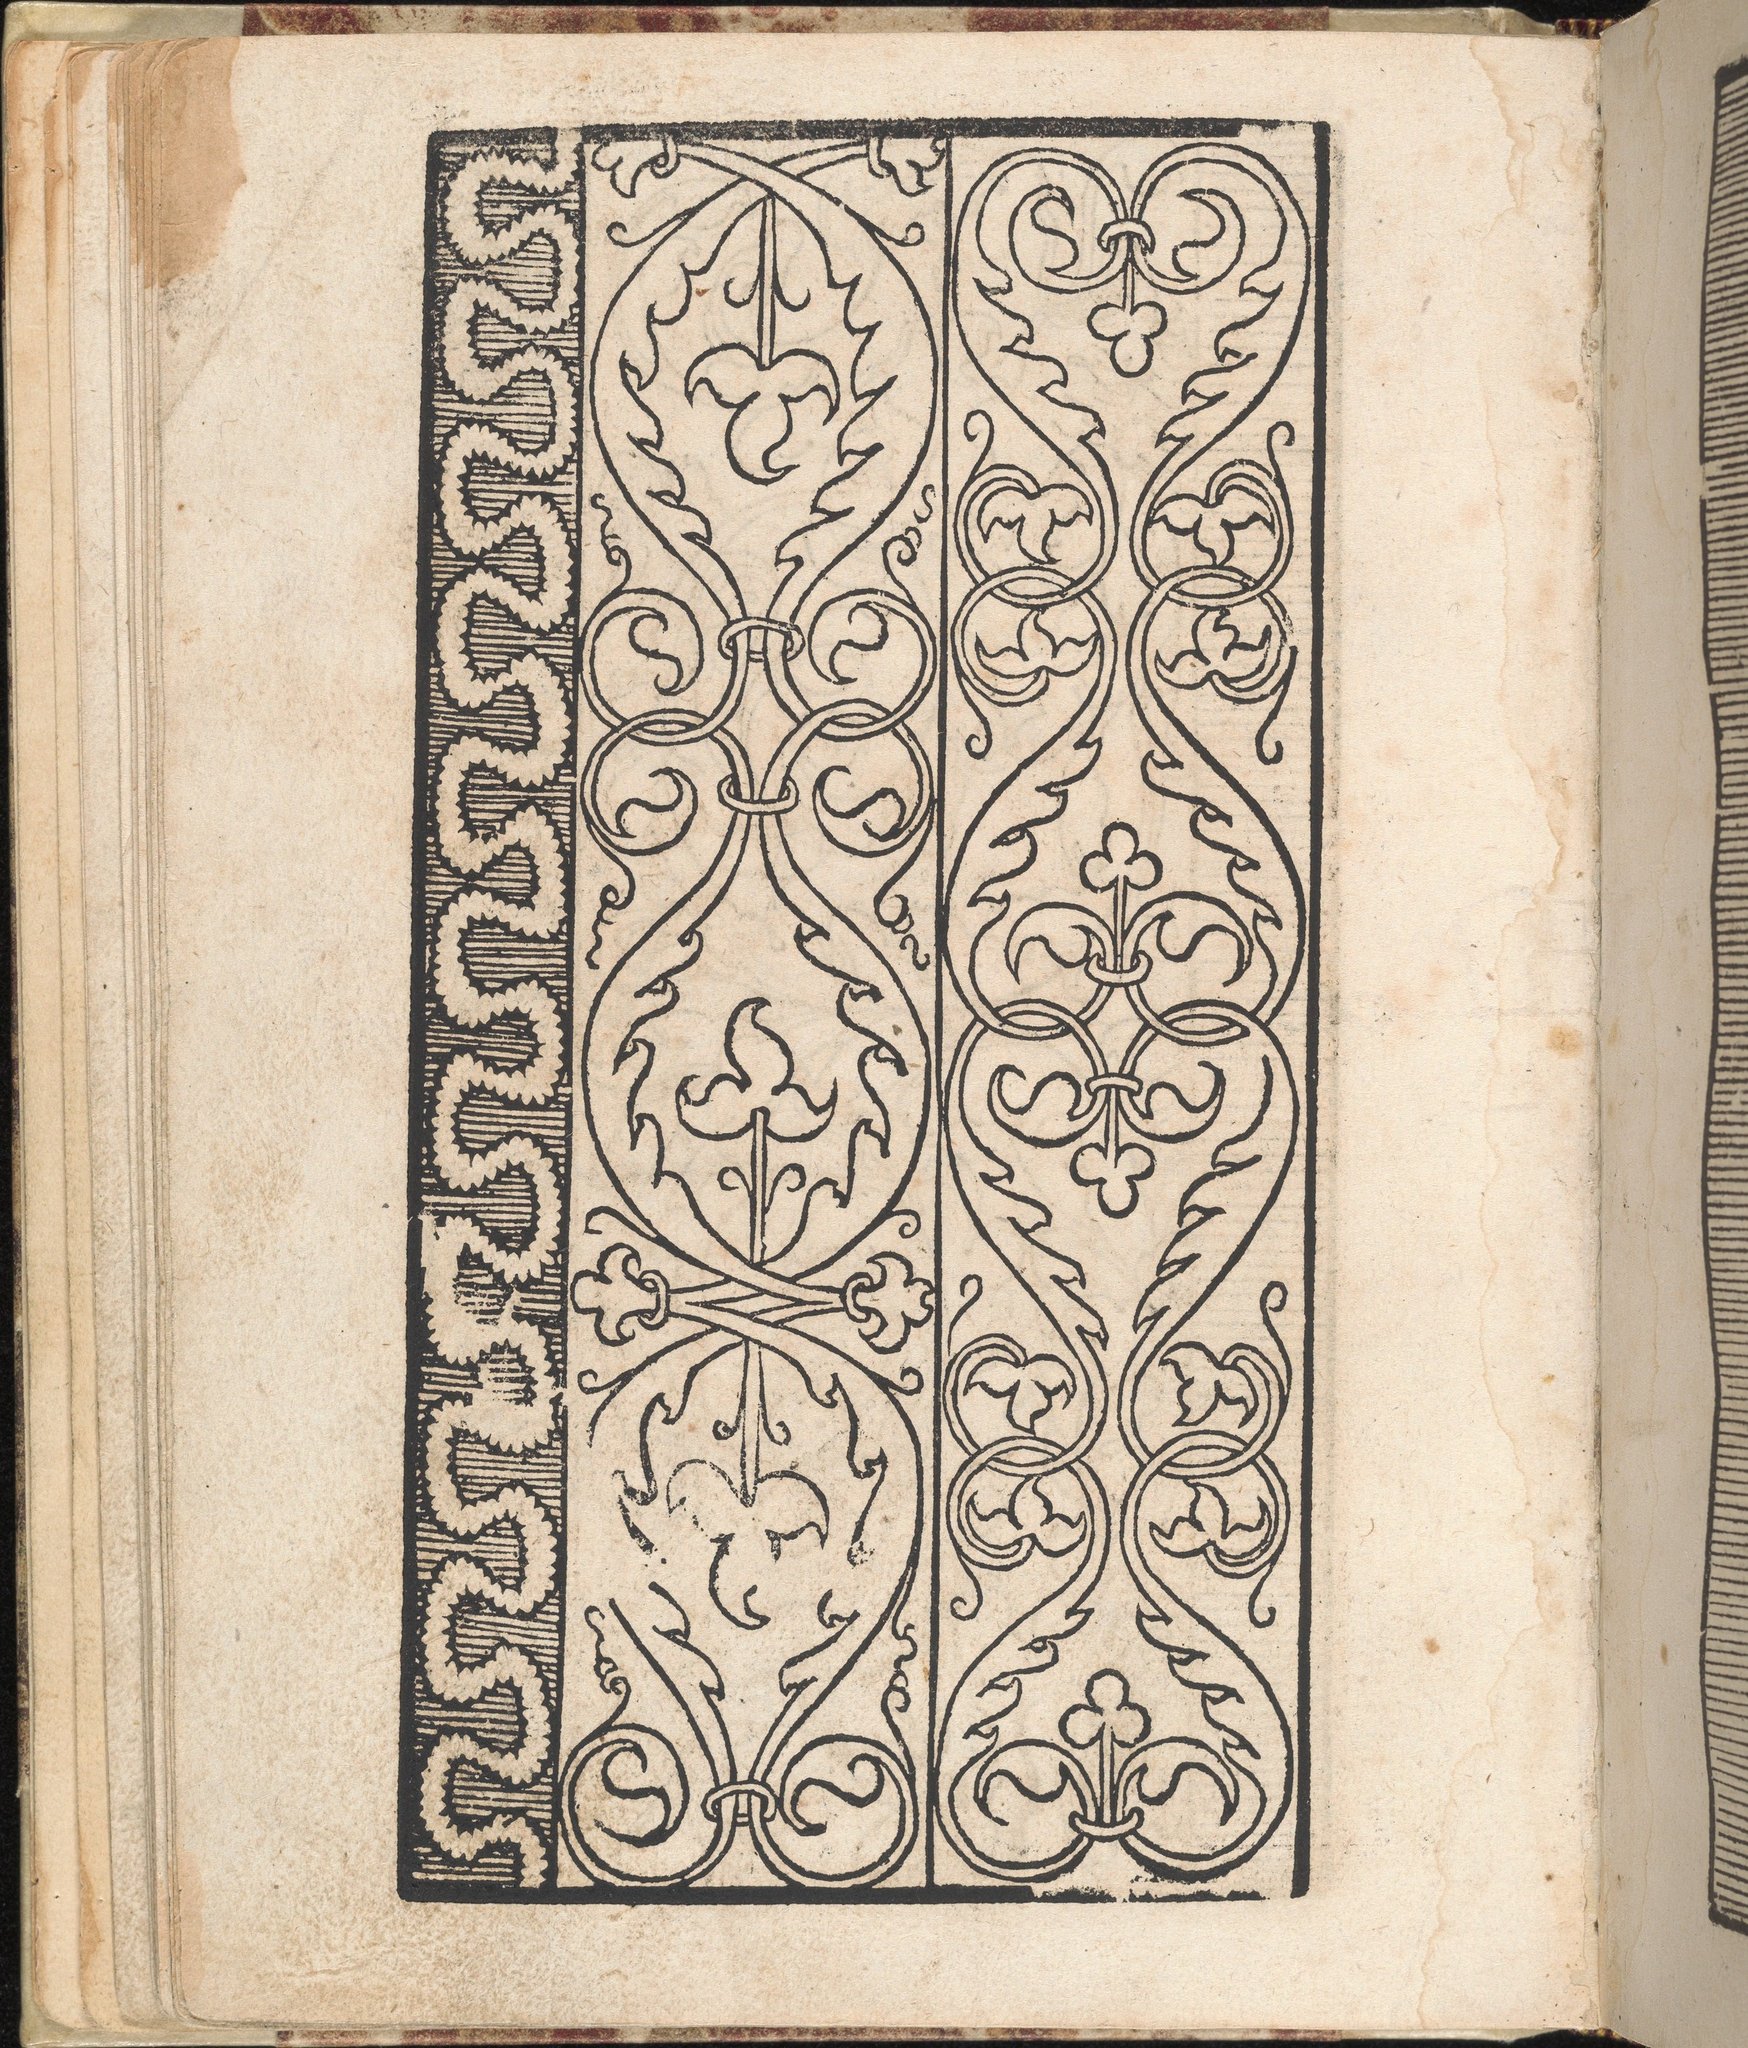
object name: book print ornament architecture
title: Ein new getruckt model Büchli...Page 21, verso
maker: johann schönsperger the younger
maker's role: publisher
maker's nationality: german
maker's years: 1490-1550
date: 1529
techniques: woodcut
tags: ornament